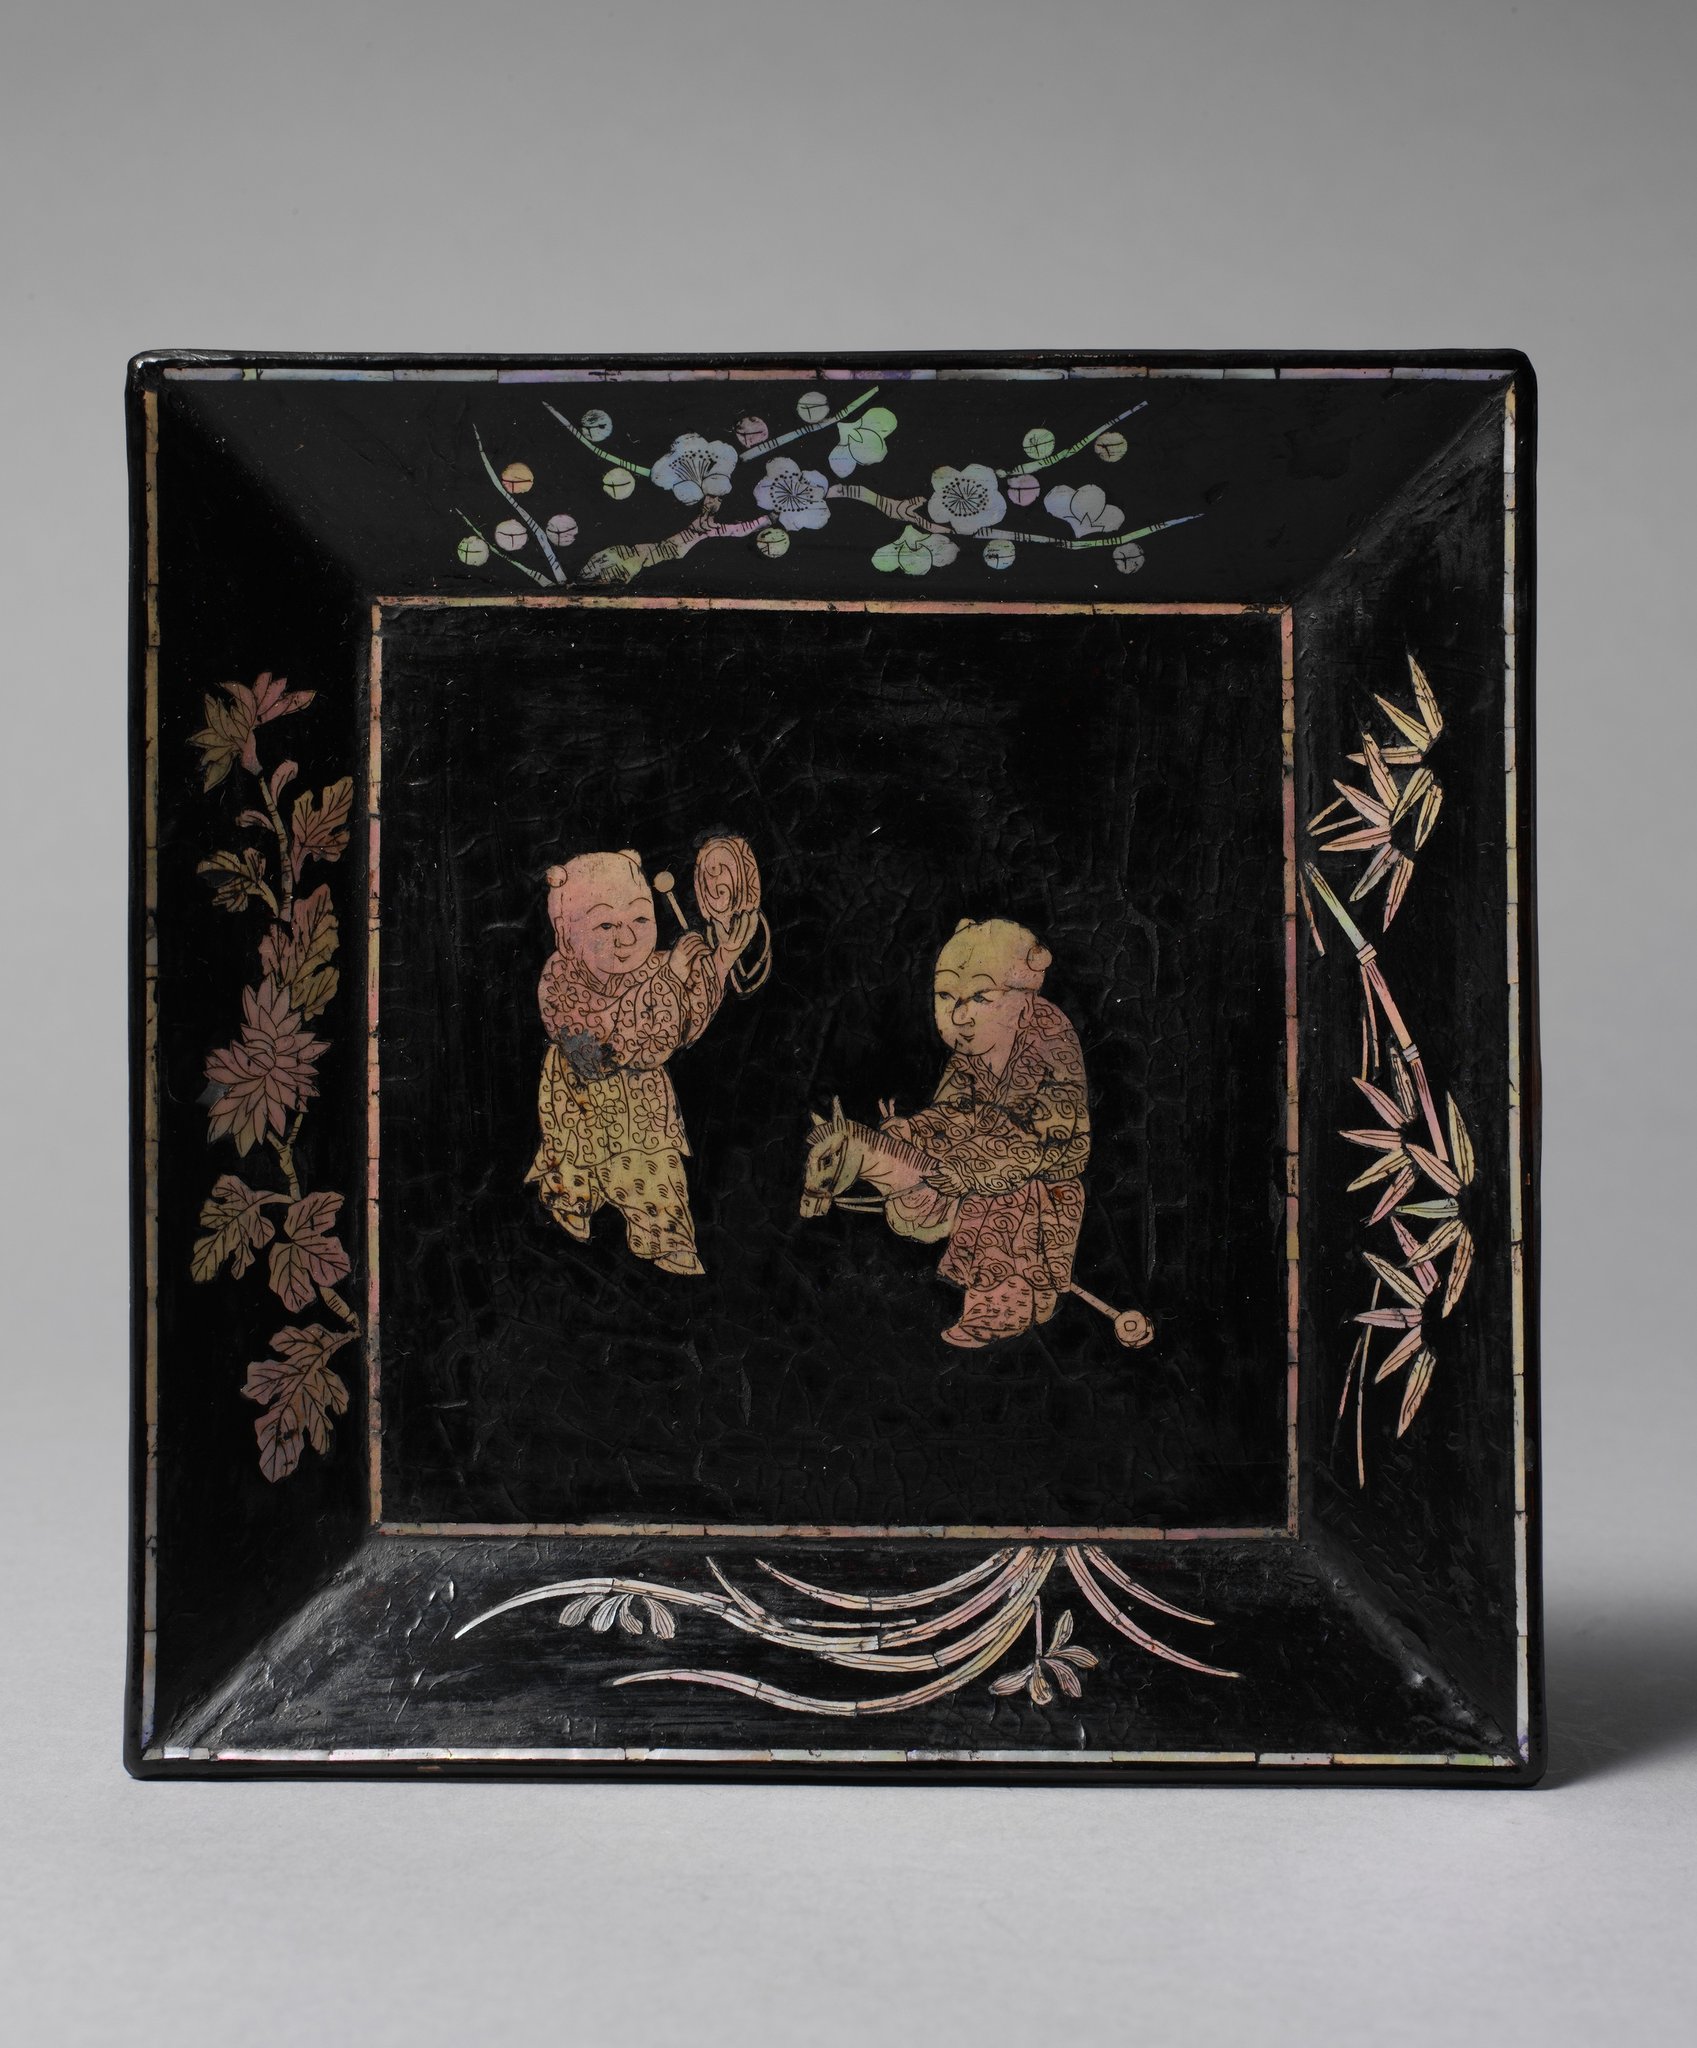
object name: dish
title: Dish with two boys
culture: chinese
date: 1501-1600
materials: lacquer, mother of pearl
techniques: inlay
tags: boys,playing,toys